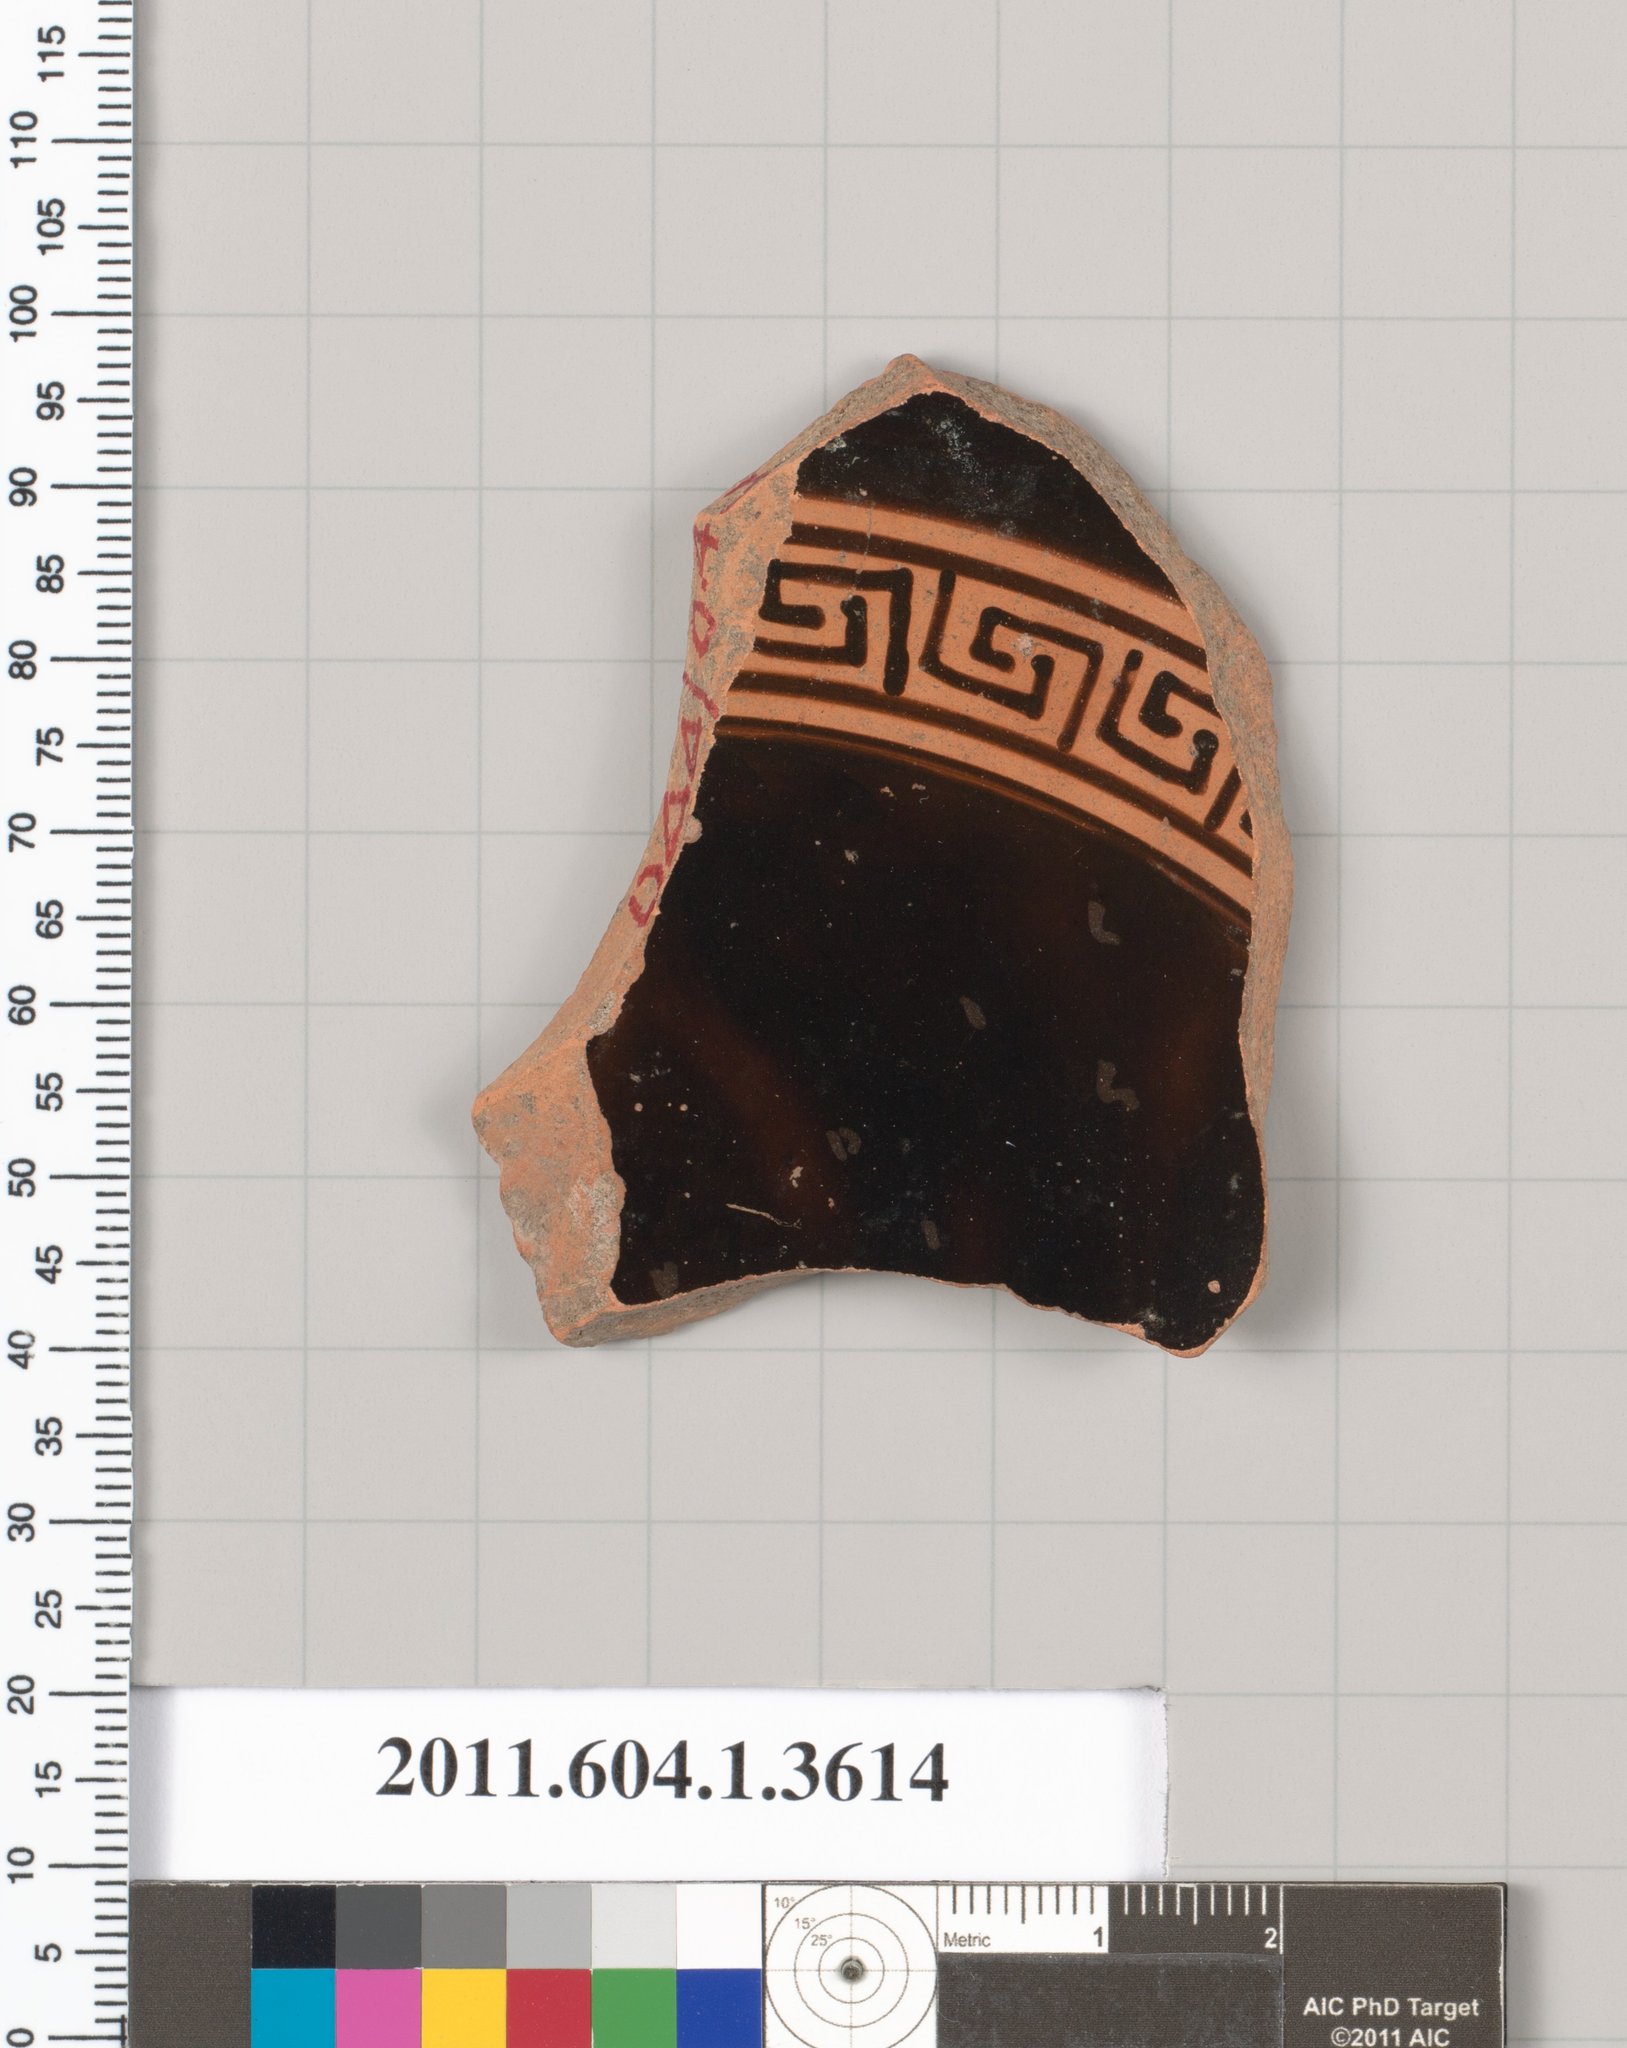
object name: kylix fragment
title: Terracotta fragment of a kylix (drinking cup)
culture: greek, attic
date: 475-451 BCE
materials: terracotta